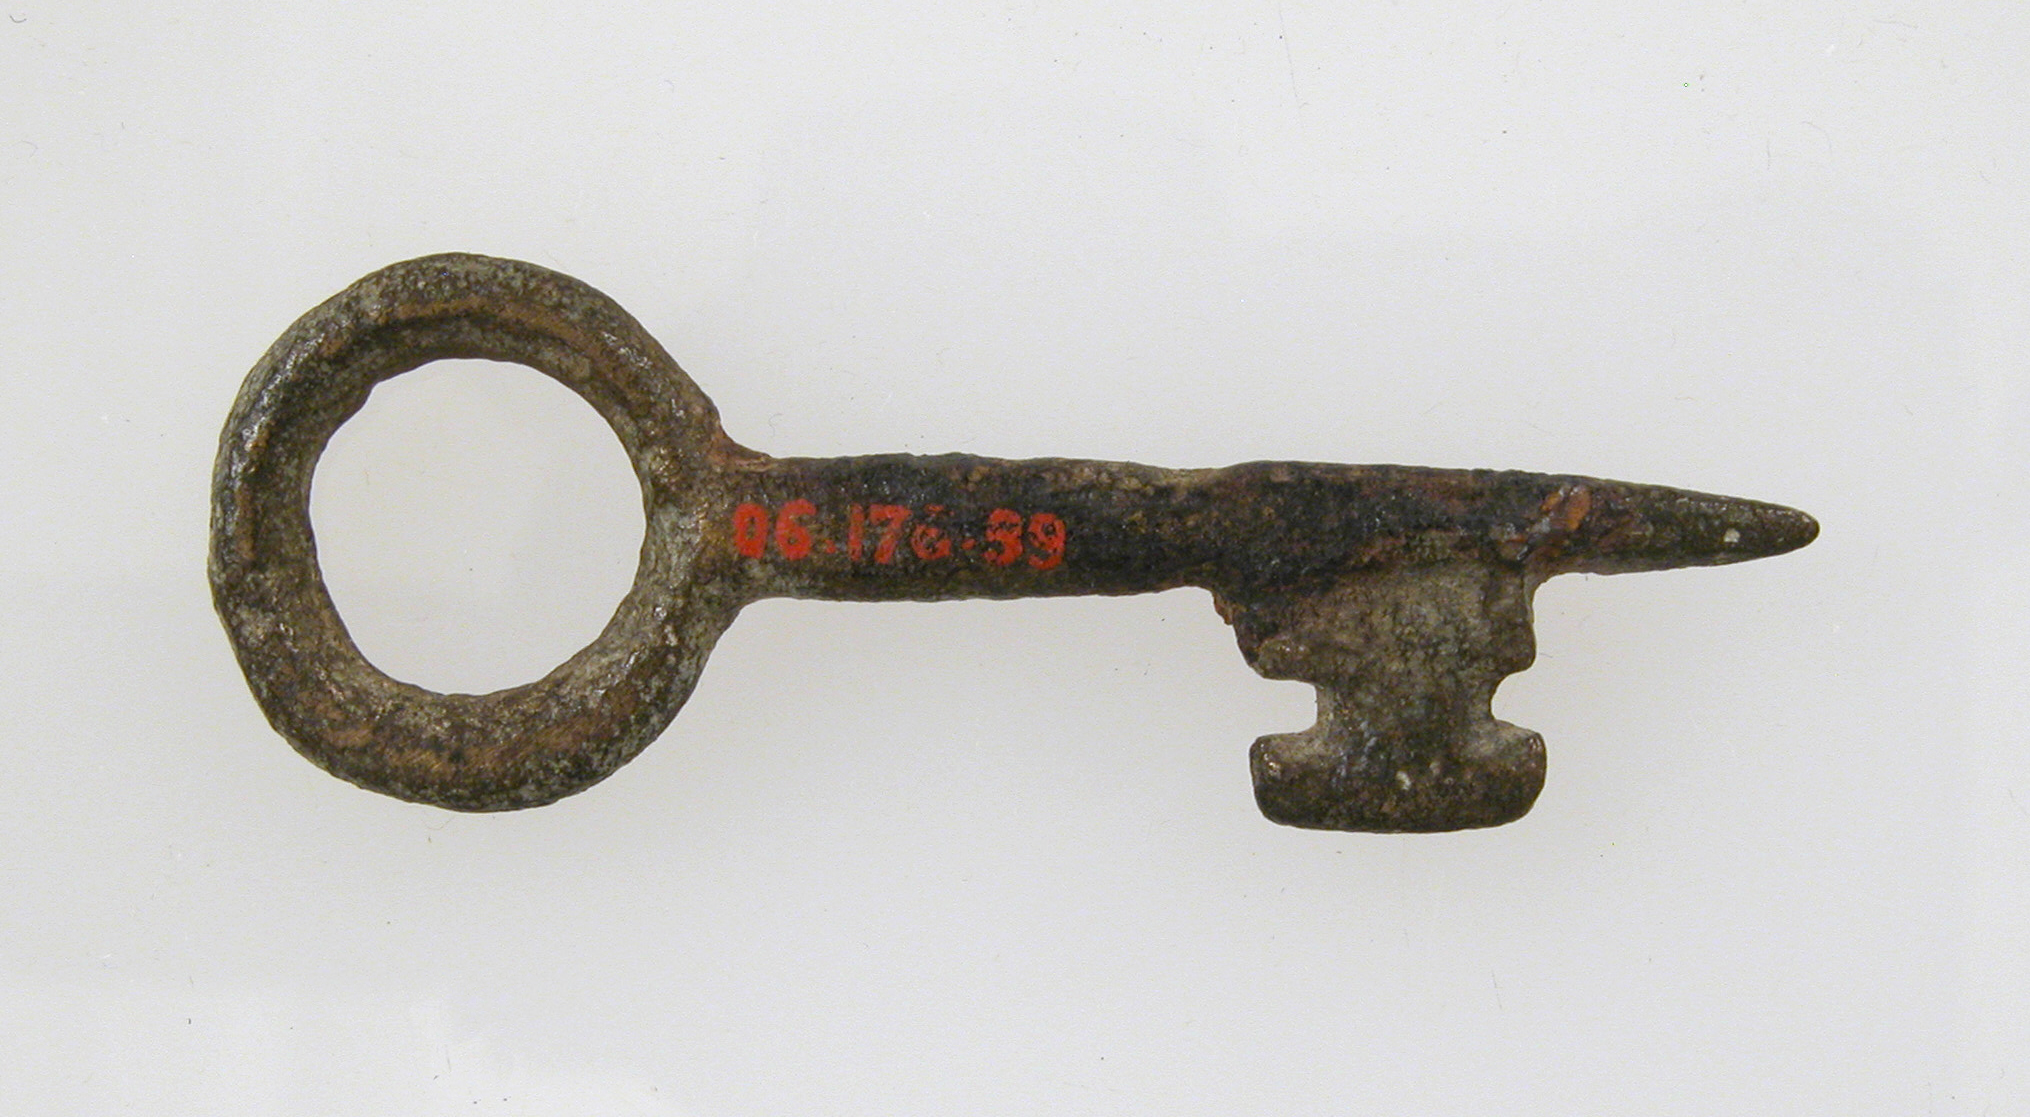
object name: key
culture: roman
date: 1-700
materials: copper alloy